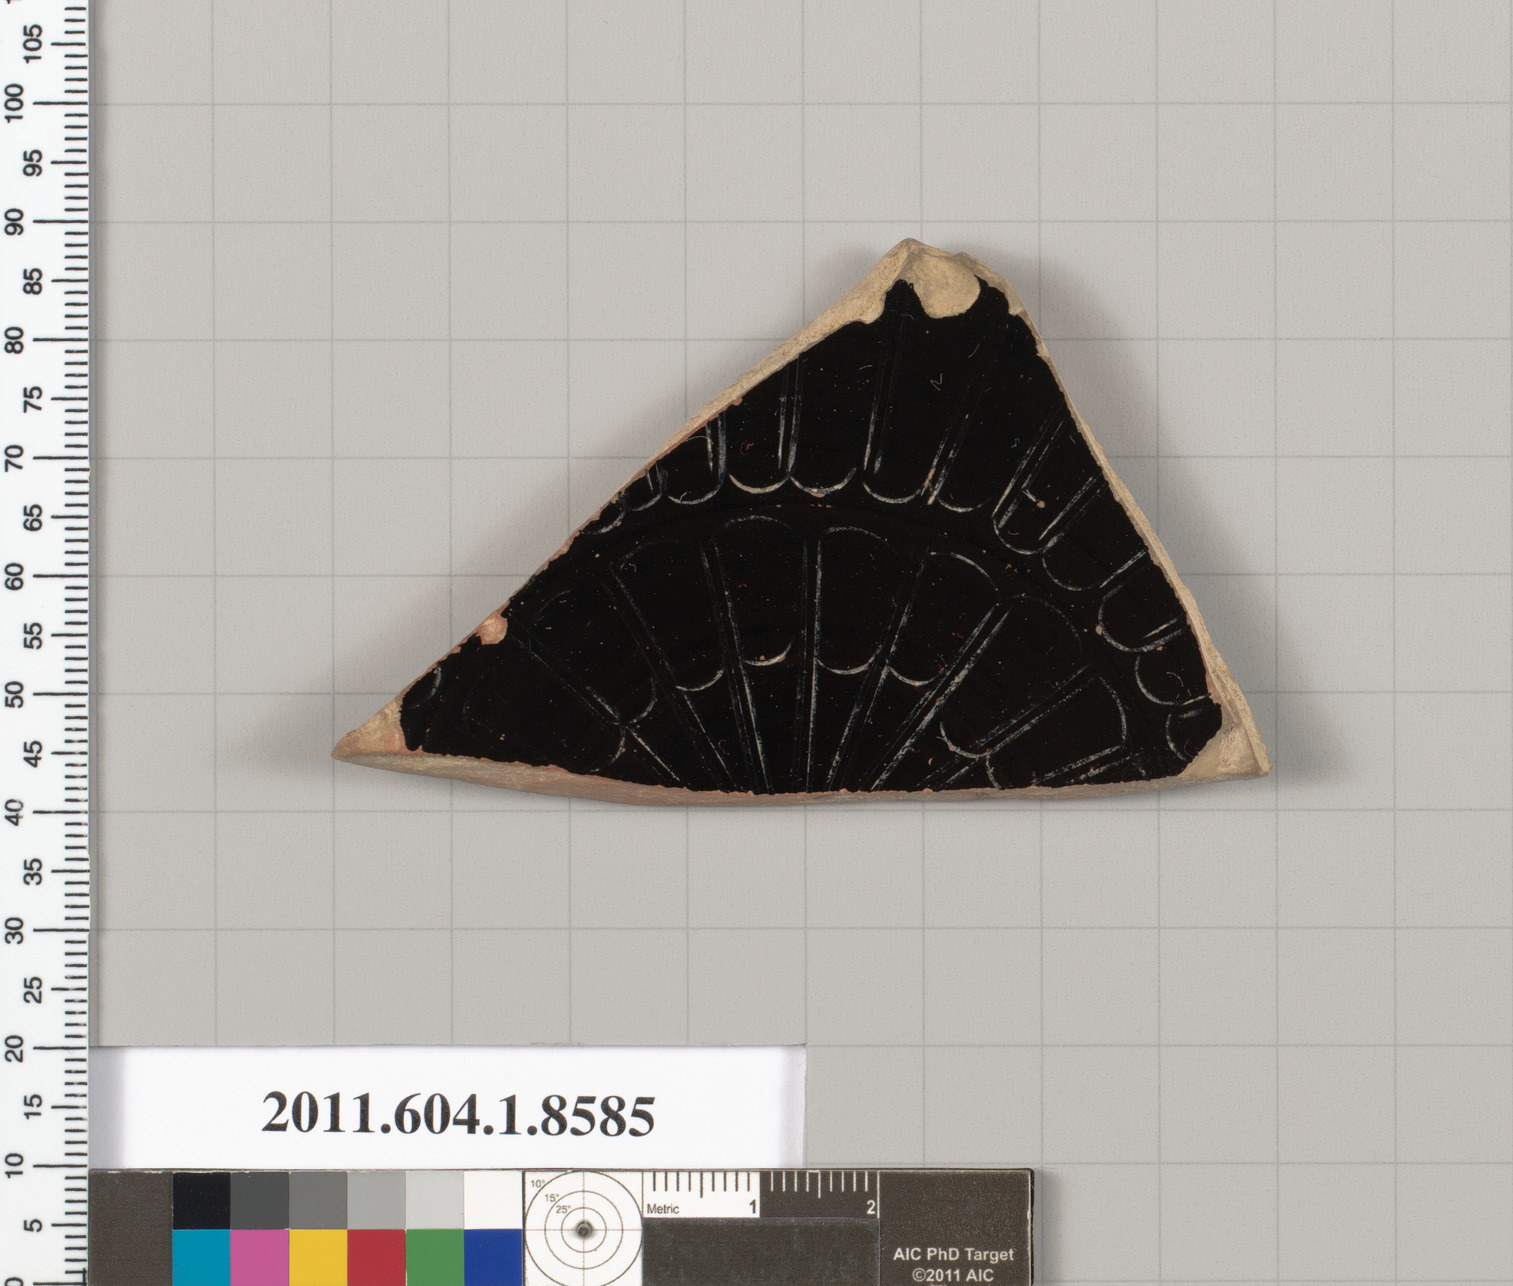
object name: kylix fragment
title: Terracotta fragment of a stemless kylix (drinking cup)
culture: greek, attic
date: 480-470 BCE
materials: terracotta